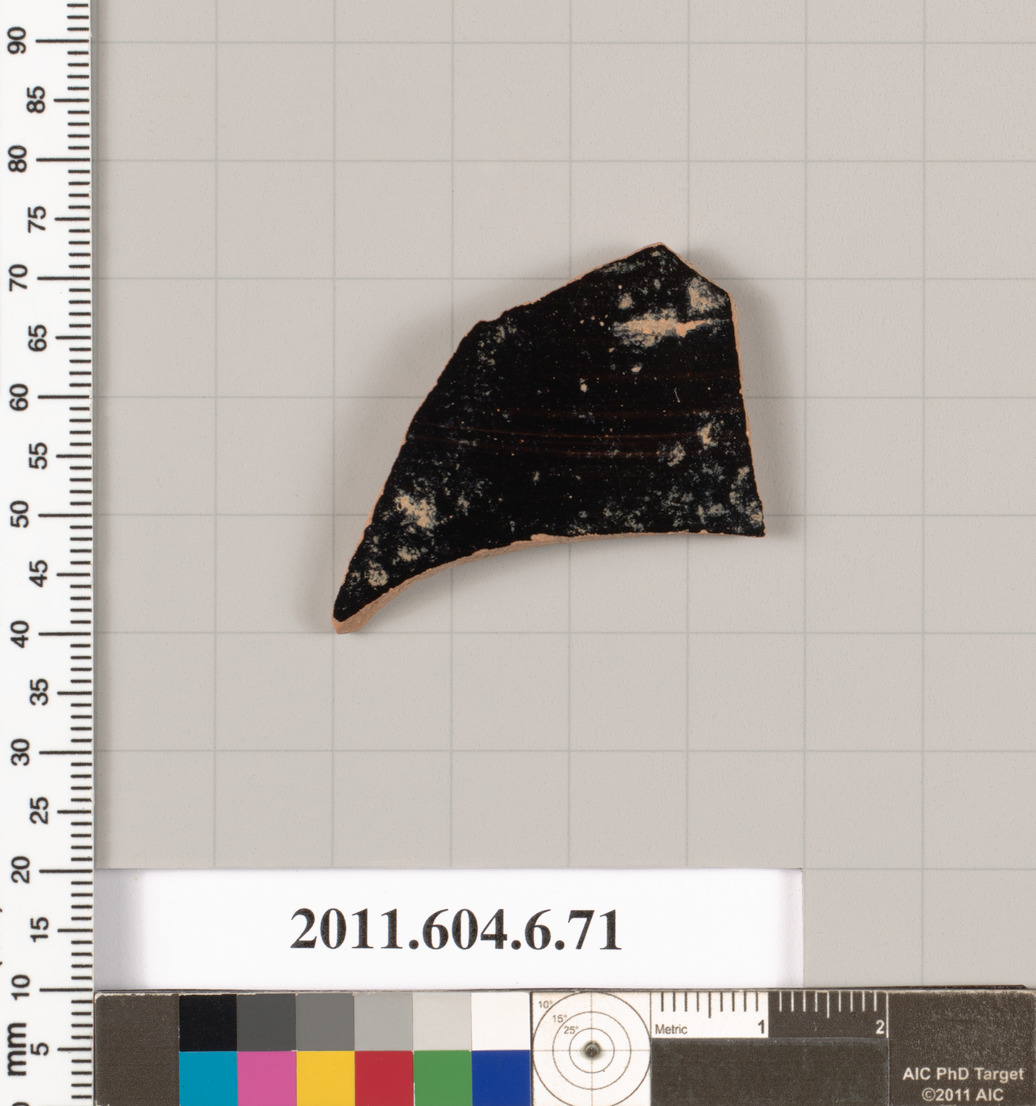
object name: undetermined shape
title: Terracotta fragment of an undetermined shape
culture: greek, attic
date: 600-401 BCE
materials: terracotta